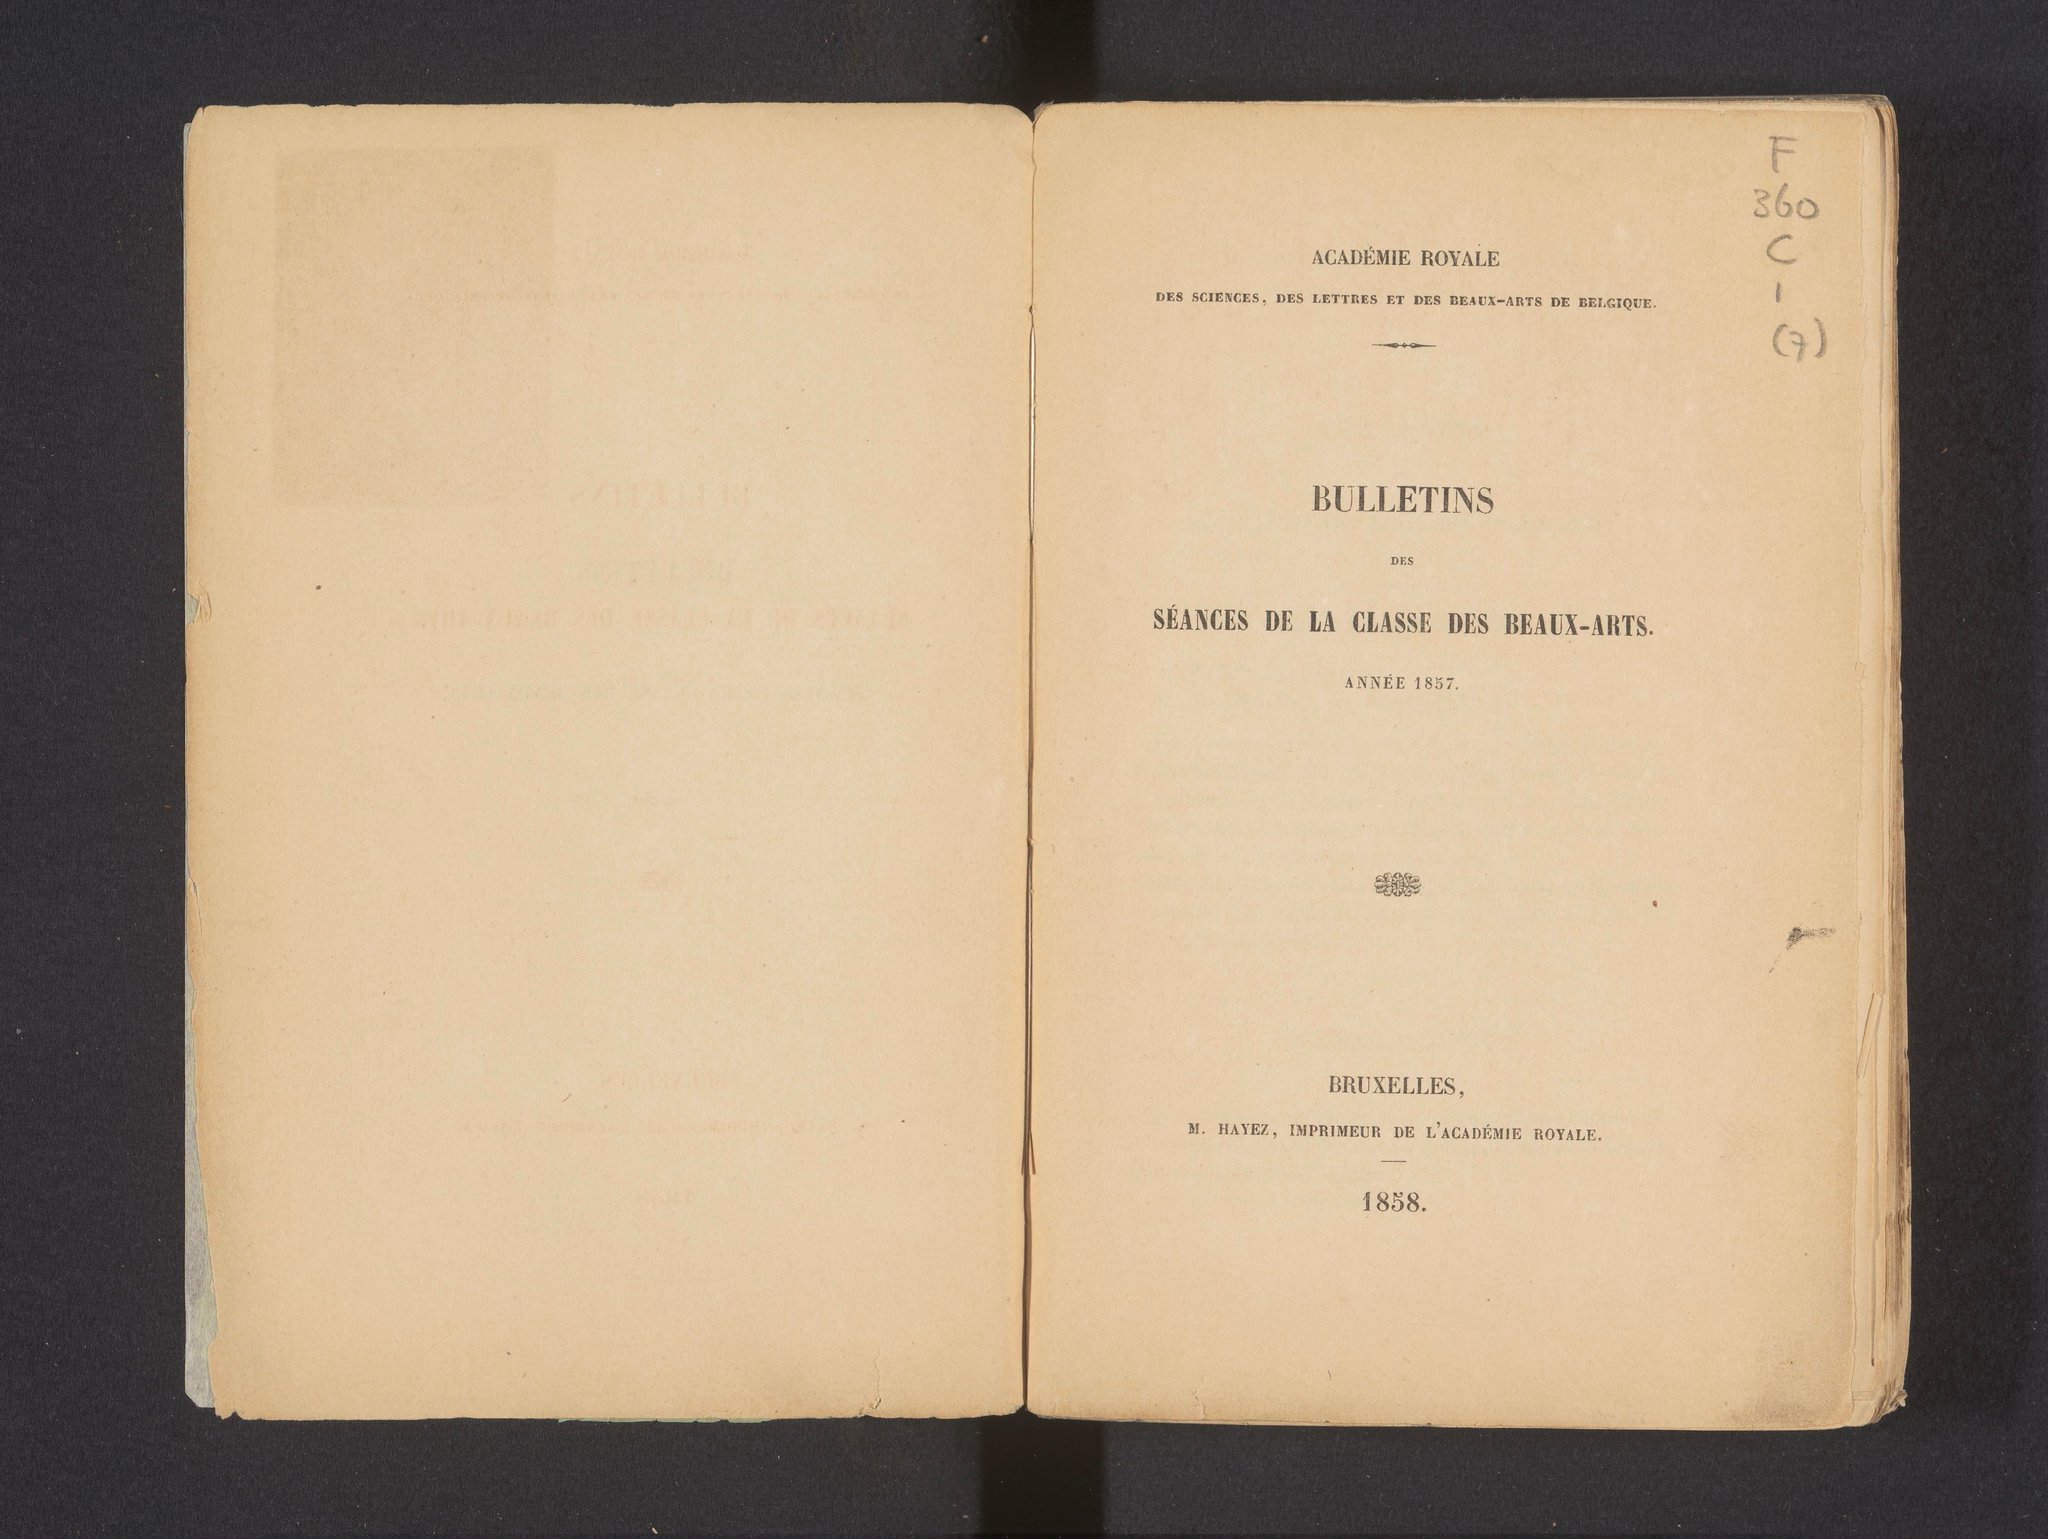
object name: magazine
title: Bulletins des séances de la Classe des beaux-arts / Académie royale des sciences, des lettres et des beaux-arts de Belgique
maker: m. hayez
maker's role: publisher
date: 1858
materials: paper, photographic support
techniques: lithograph, printing, salted paper print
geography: brussels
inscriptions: bookplate: ‘MUSEUM/ ARTIUM/ Prov. Belg. S. I’, annotation: ‘OCT/ 1992’